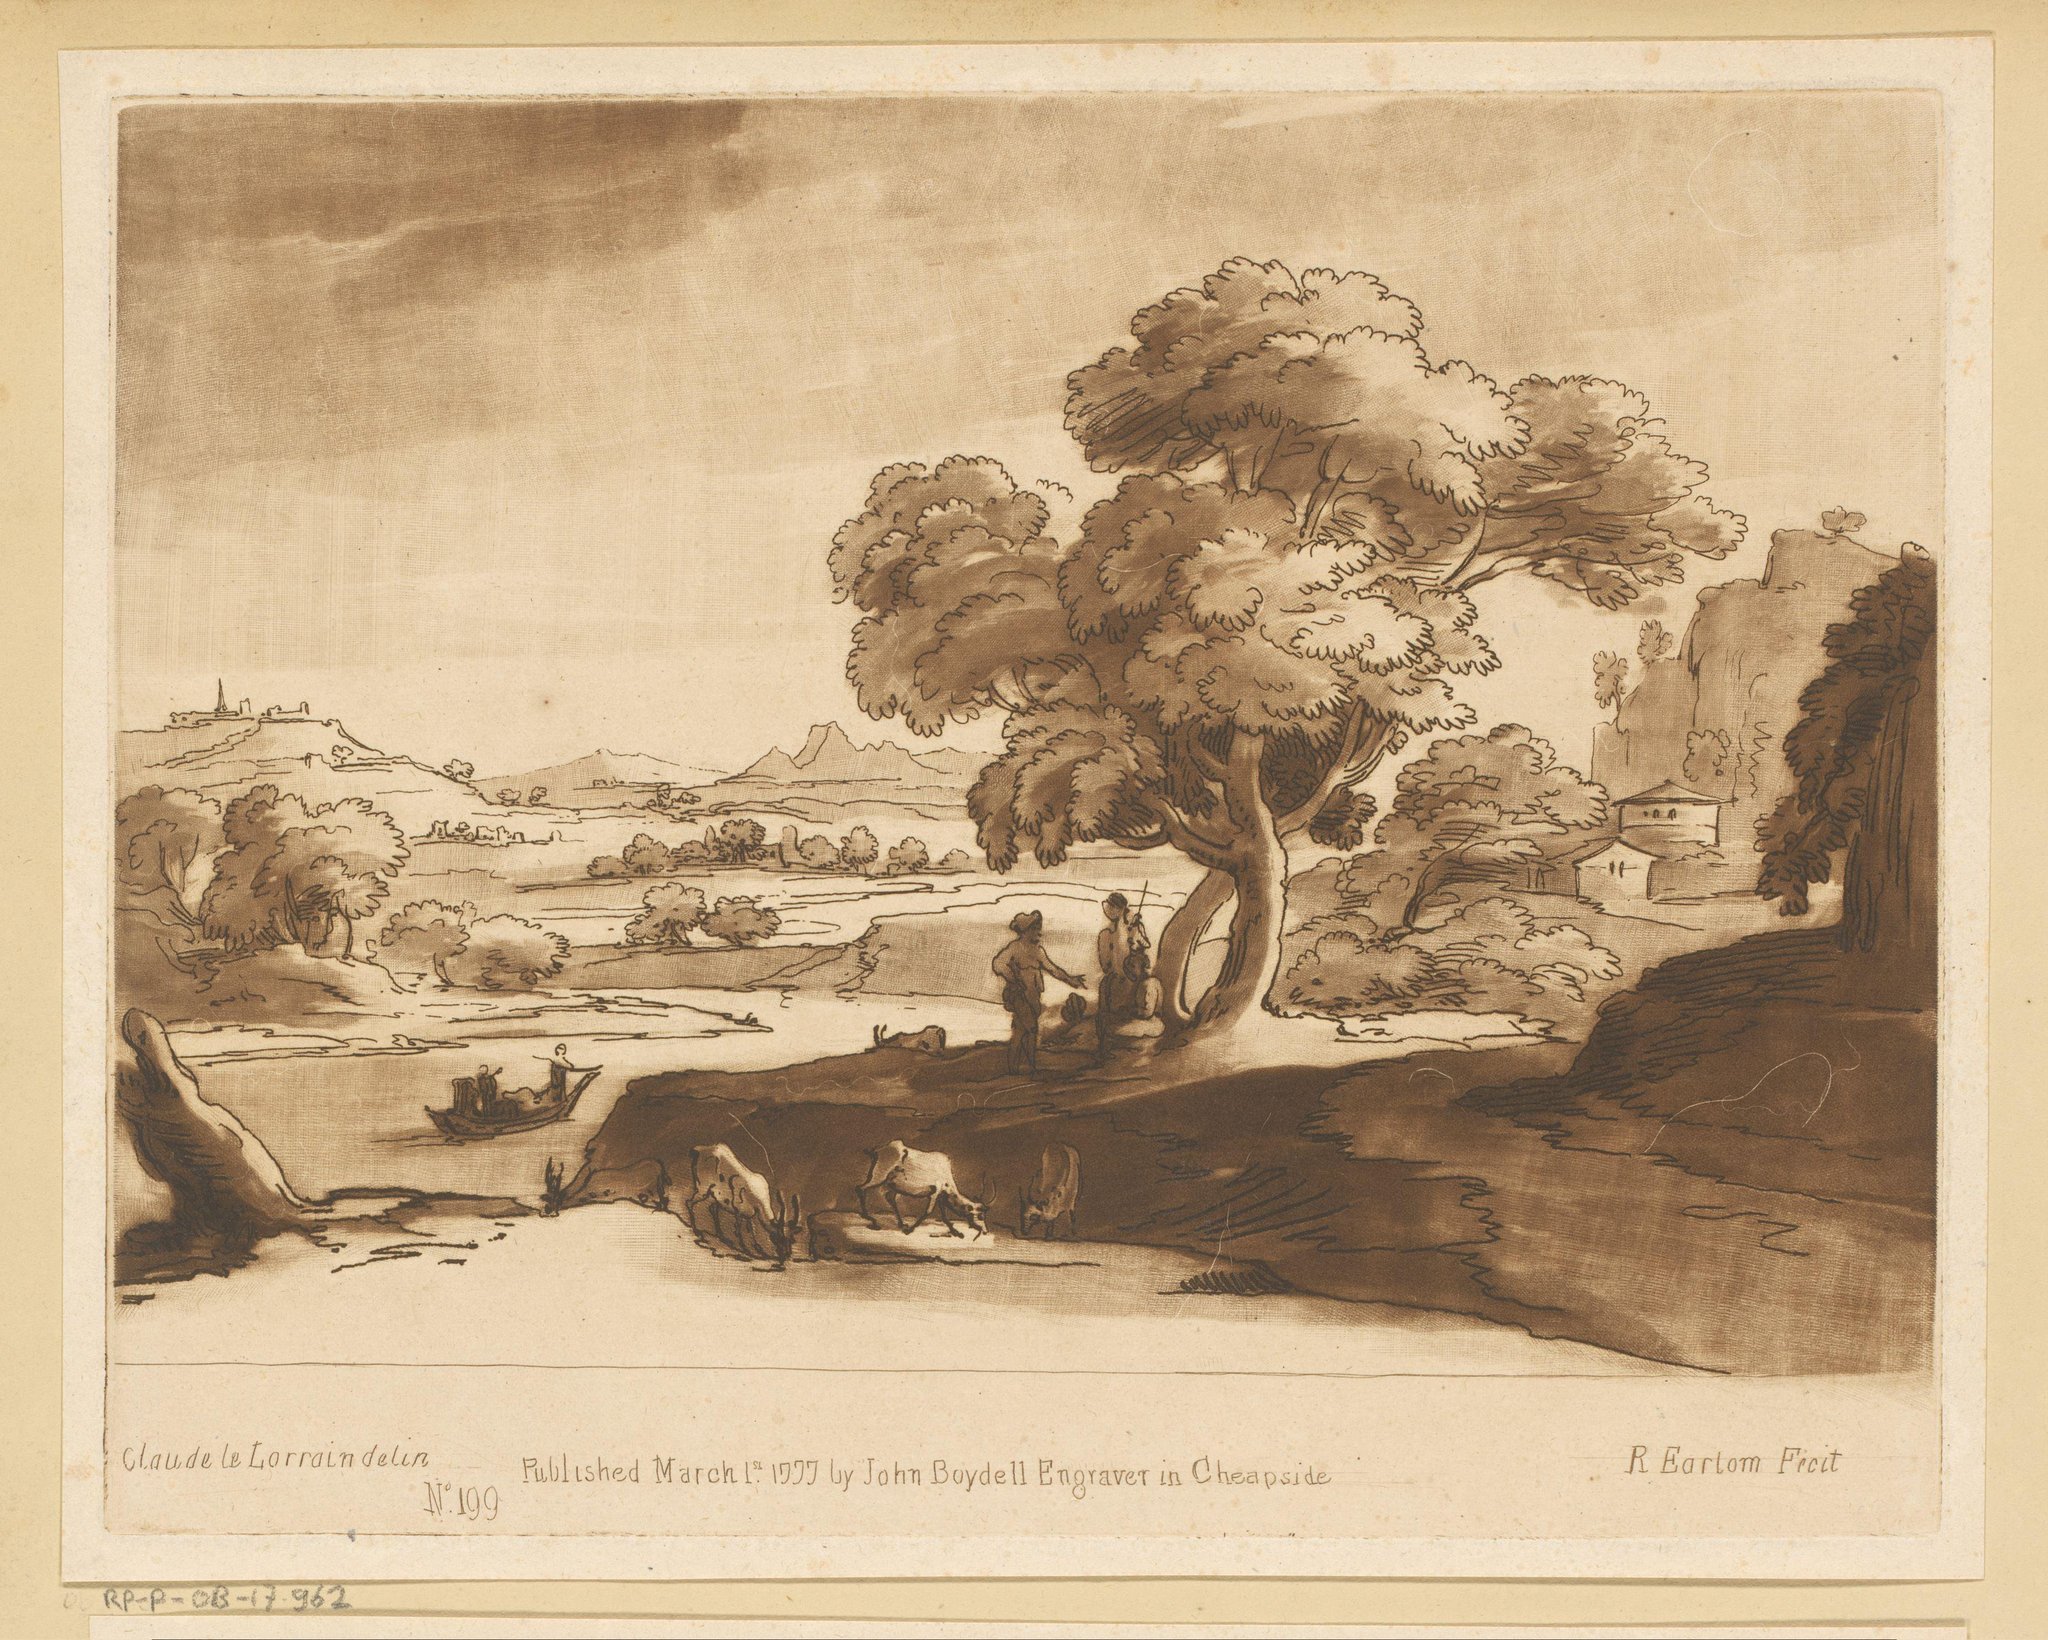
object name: print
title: Landschap met roeiboot op een rivier, drie herders en vee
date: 1777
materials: paper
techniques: etching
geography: london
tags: river - hh - ideal landscapes, herding, herdsman, herdswoman, shepherd, shepherdess, cowherd, etc., cattle, pastorals, arcadian scenes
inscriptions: date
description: Vanaf 1774 publiceerde John Boydell tweehonderd prenten naar het tekeningenboek Liber Veritatis van Claude Lorrain, in het bezit van de hertogen van Cavendish. Deze prenten werden vanaf 1777 in twee volumes gebundeld uitgegeven.